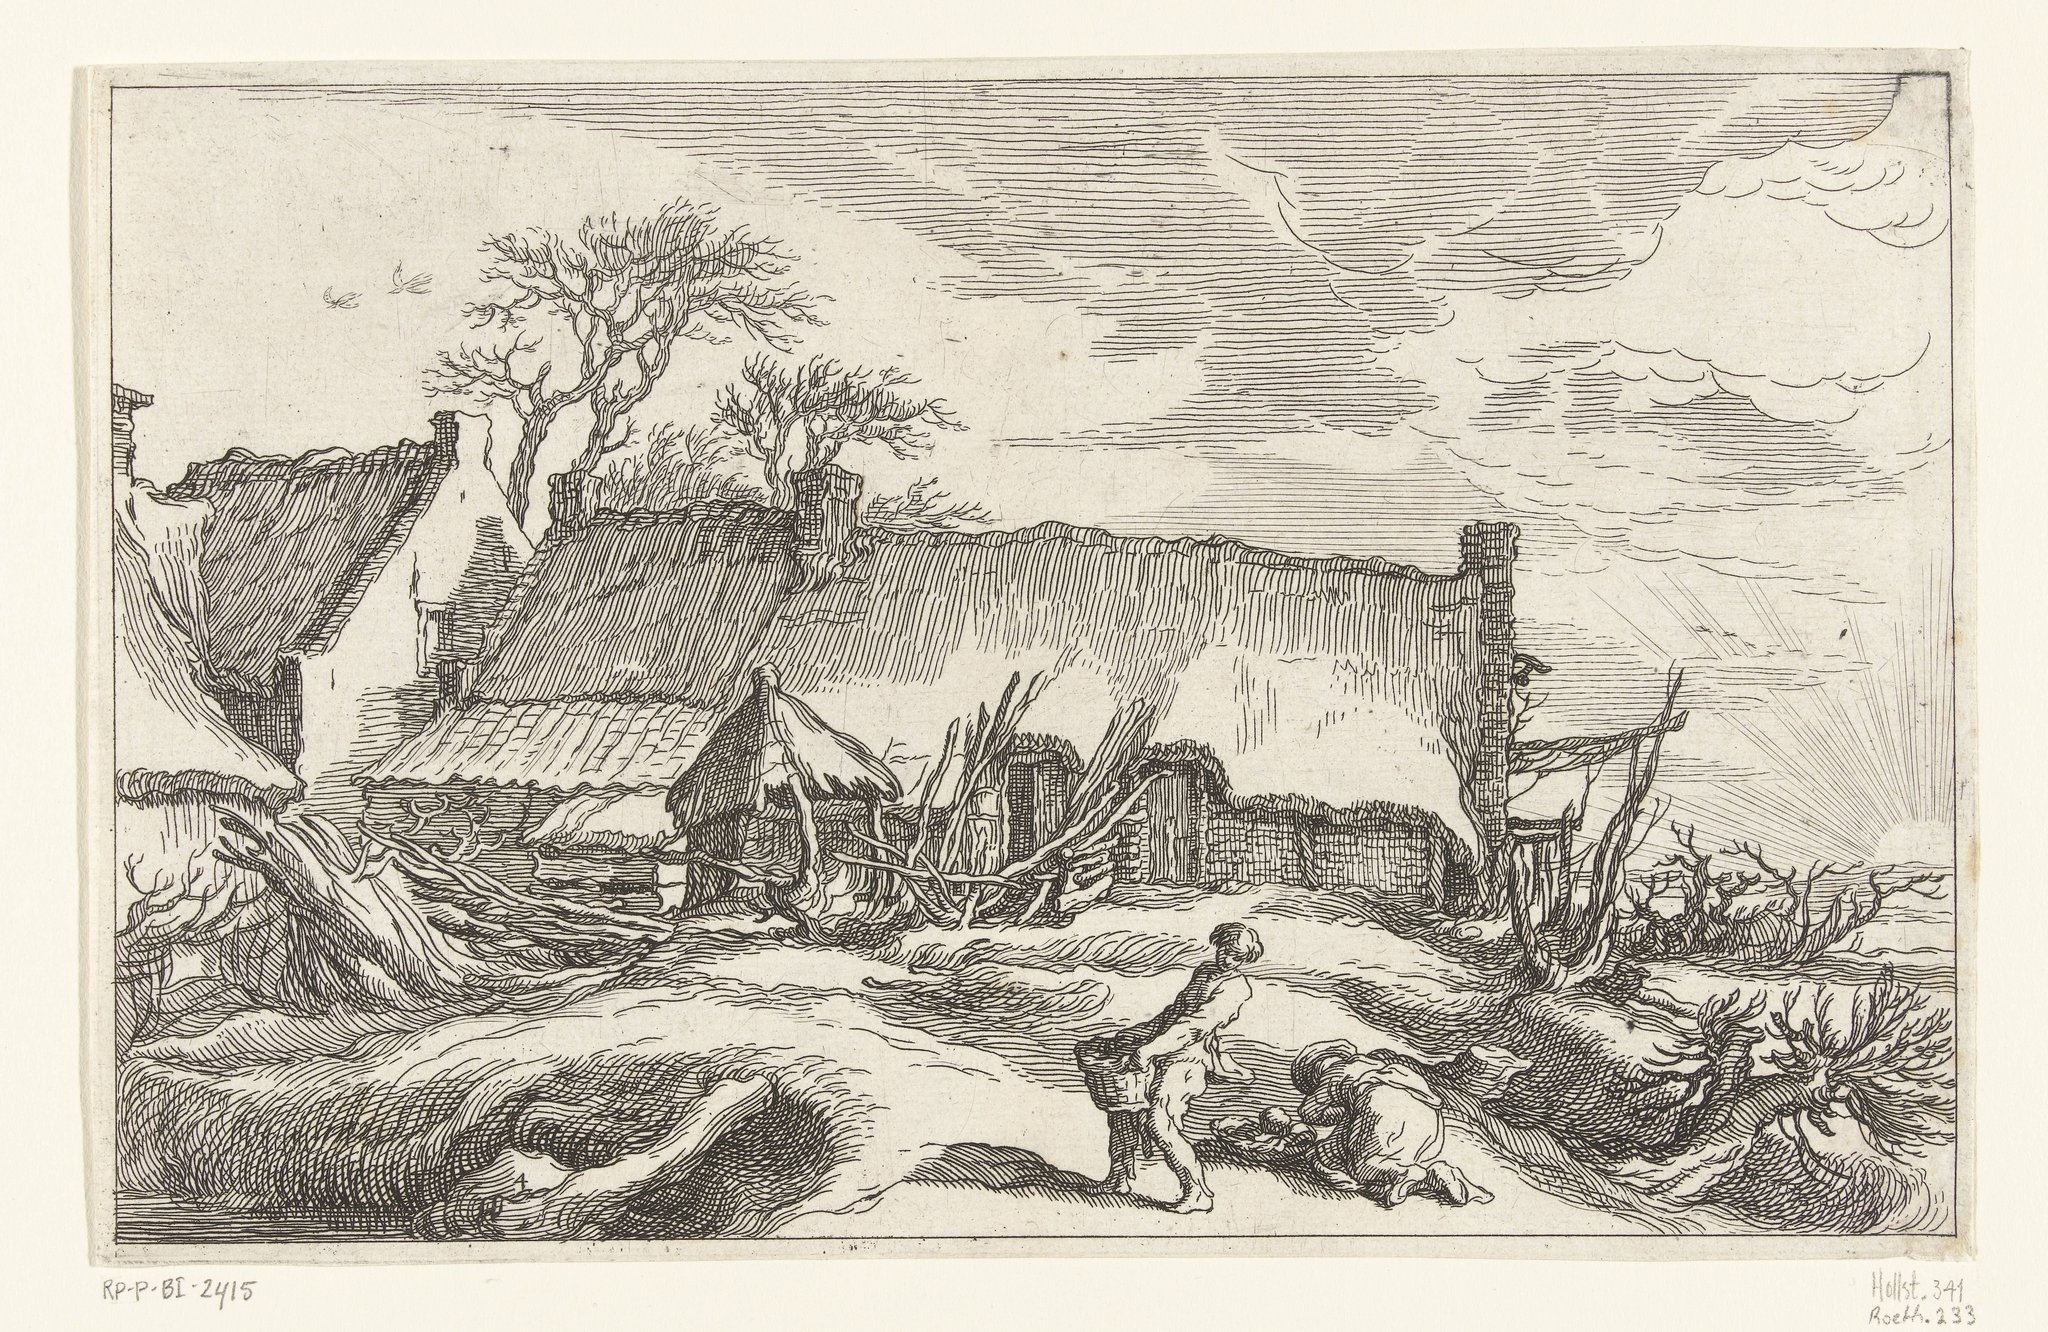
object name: print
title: Boerderij met opkomende of ondergaande zon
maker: boëtius adamsz. bolswert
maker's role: print maker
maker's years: 1580-1633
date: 1614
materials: paper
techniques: etching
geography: amsterdam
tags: farm or solitary house in landscape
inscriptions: collector's mark: Lugt 240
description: Prent uit serie van twintig Landschappen met boerderijen naar ontwerp van Abraham Bloemaert.